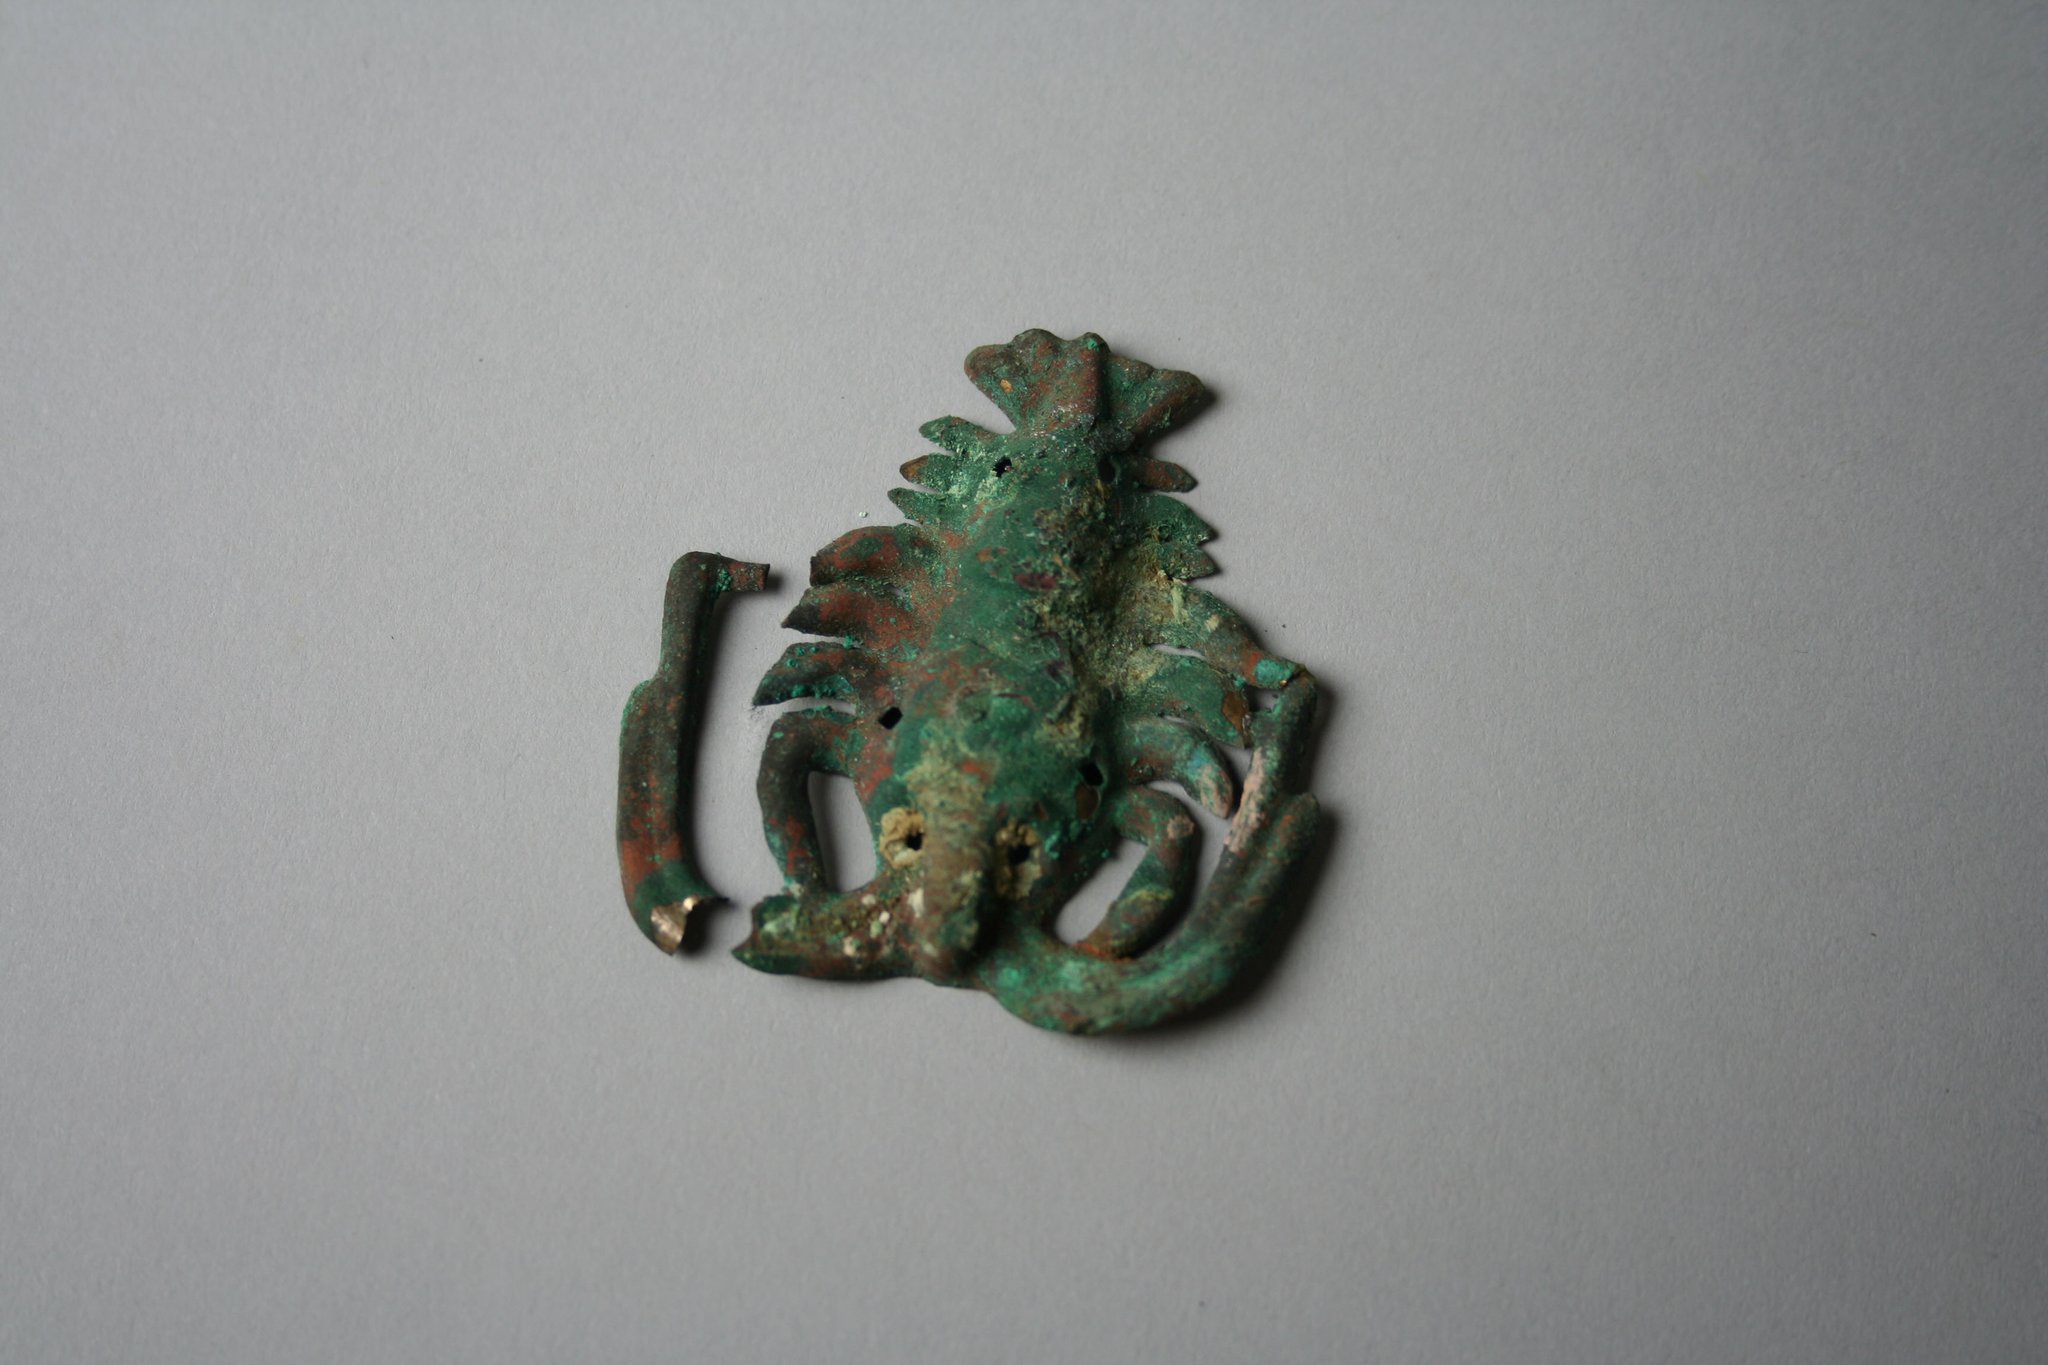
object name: ornament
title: Crayfish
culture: moche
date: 501-700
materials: gilt copper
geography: peru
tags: crayfish